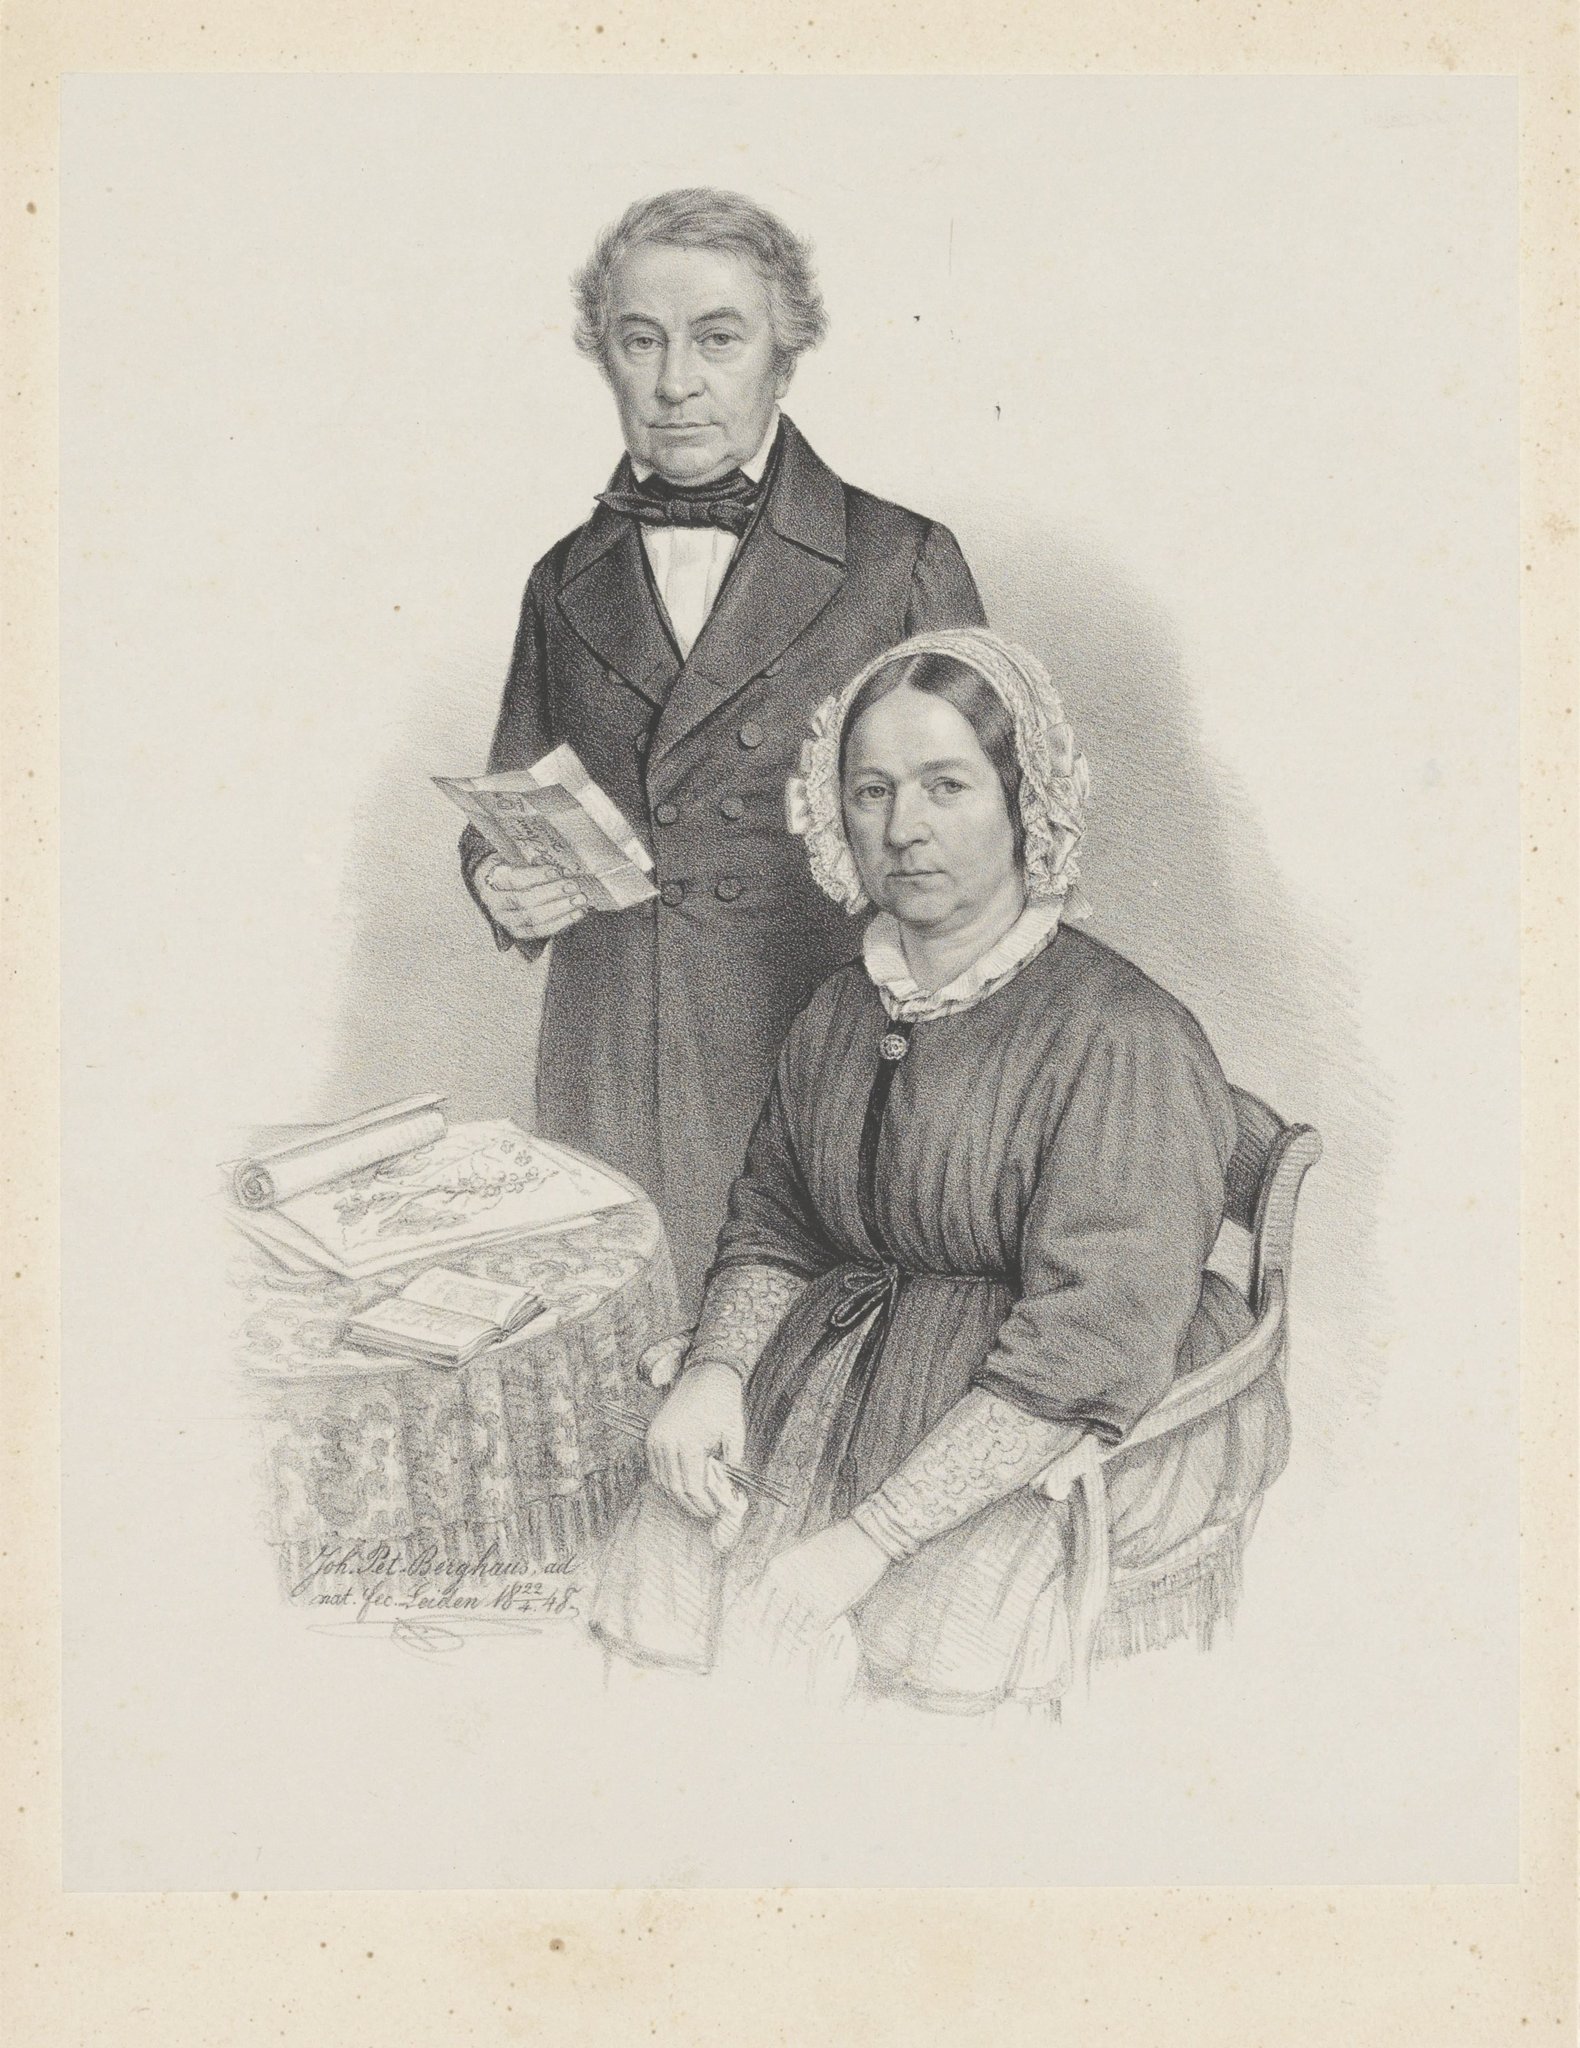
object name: print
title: Dubbelportret van de uitgever Heinrich Arnz en zijn vrouw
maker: johann peter berghaus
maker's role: print maker, printer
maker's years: 1810-1870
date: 1848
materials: paper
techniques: lithograph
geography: leiden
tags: historical persons - bb - woman, historical persons, book, knitting, letter, envelope, printed matter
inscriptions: collector's mark: Lugt 2760, collector's mark: Lugt 2228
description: De vrouw zit op een stoel. In haar rechterhand heeft zij een breiwerk. Naast haar een tafel met daarop een tafelkleed, een opengeslagen boek en enkele prenten. Achter haar staat haar man. In zijn hand heeft hij een aan hem geadresseerde brief.